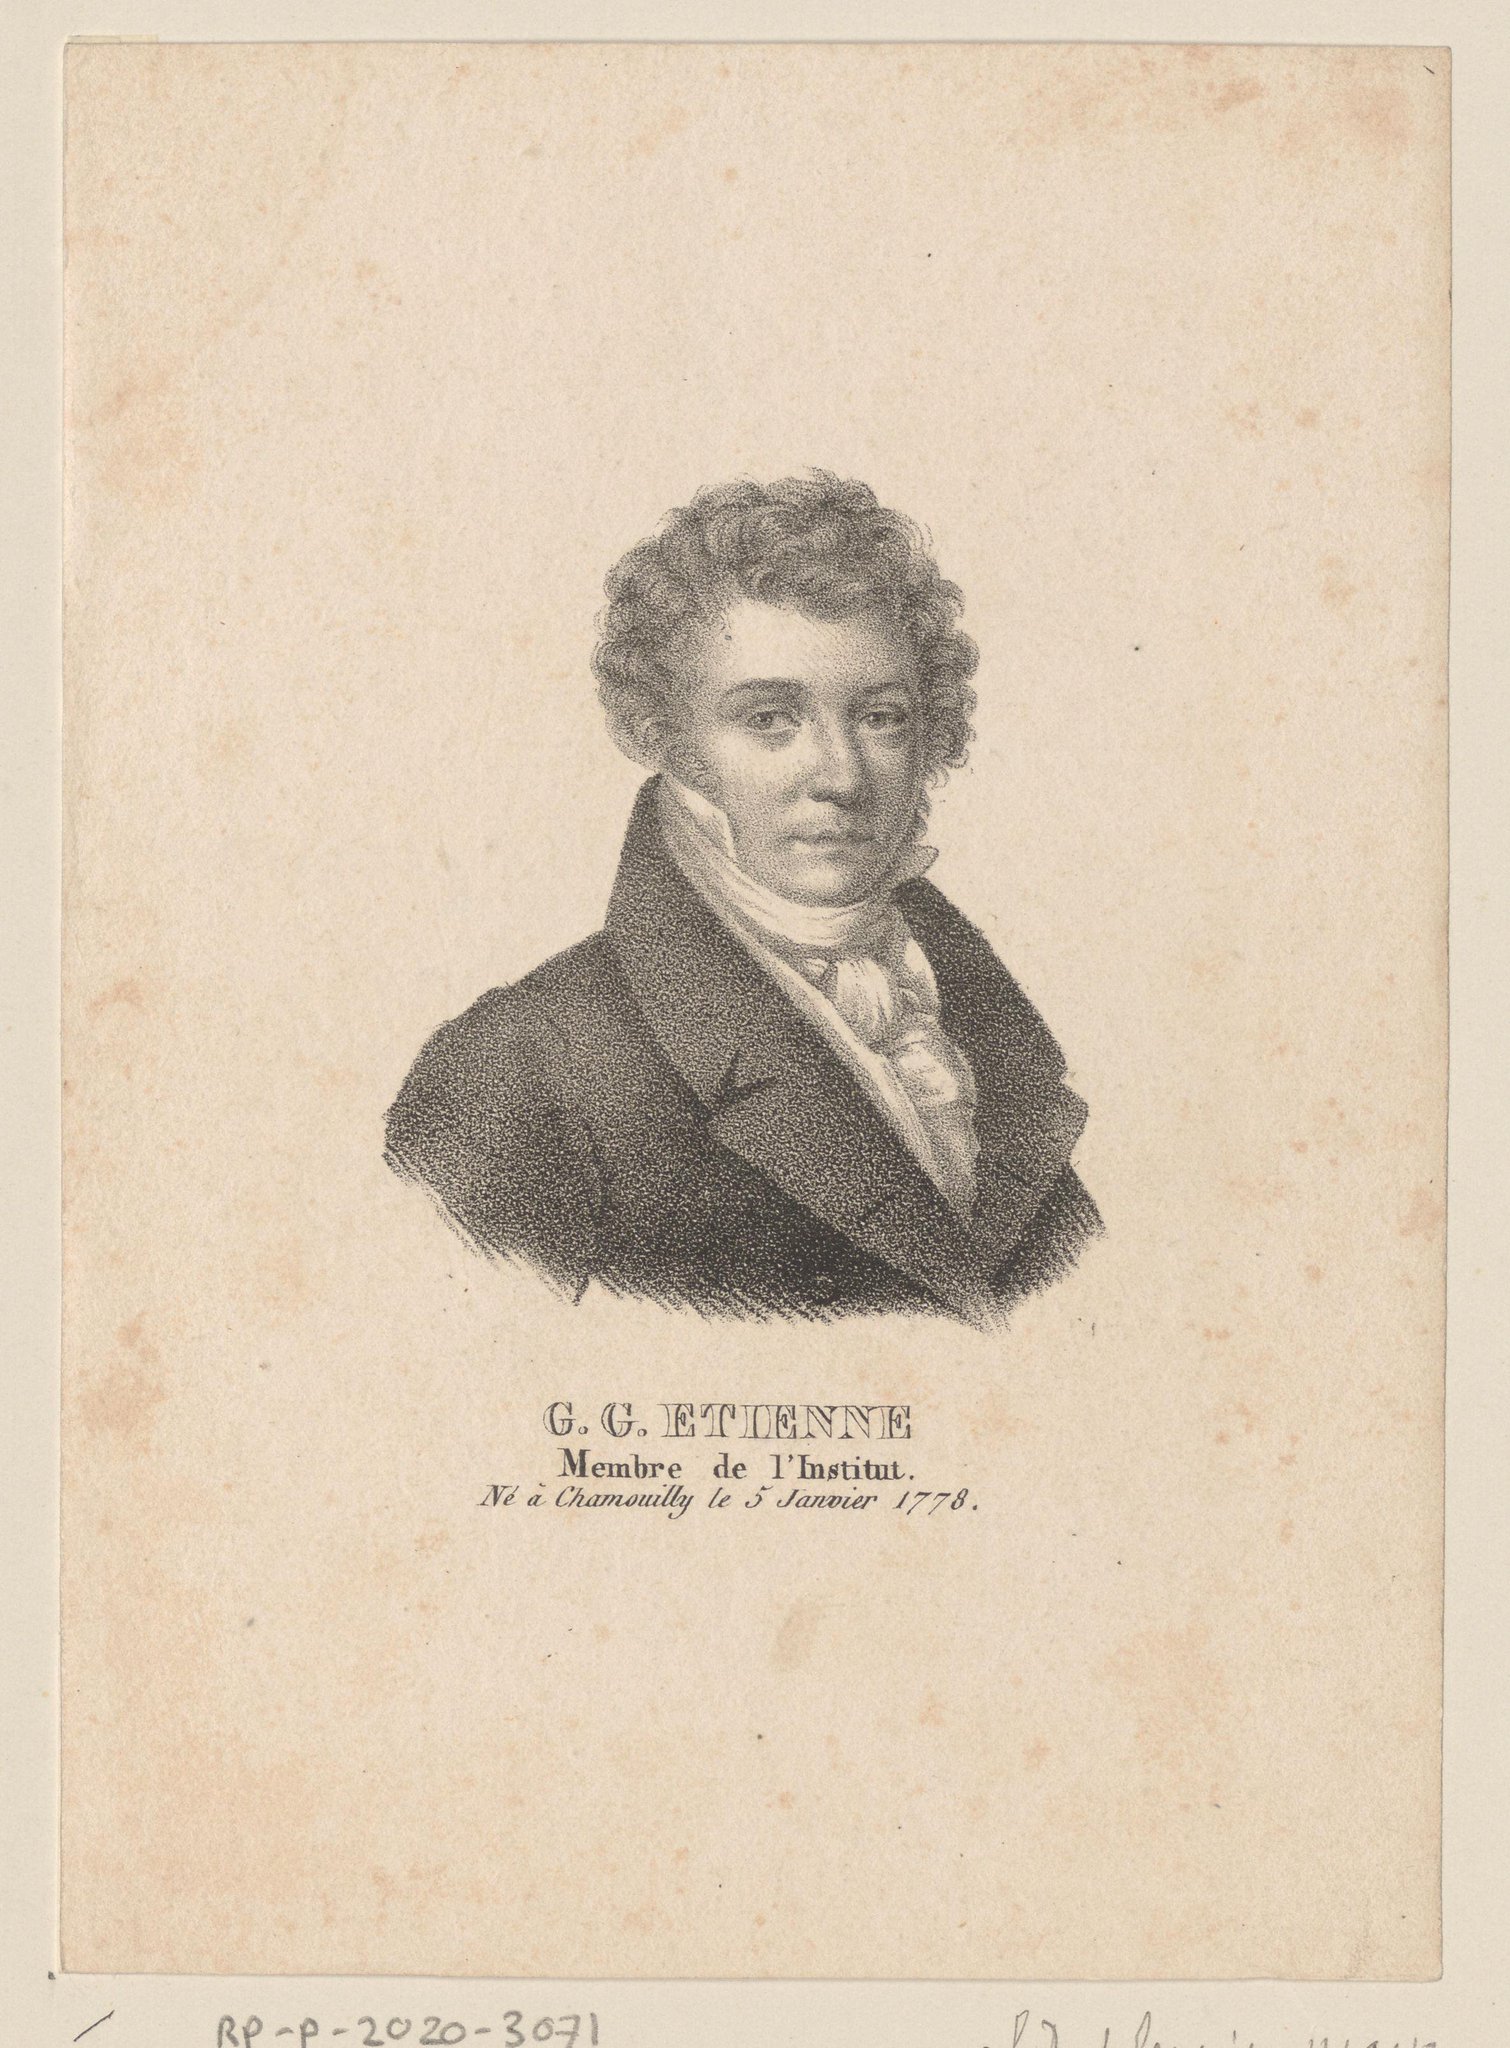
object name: print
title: Portret van Charles-Guillaume Étienne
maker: Anonymous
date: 1800-1850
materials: paper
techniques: lithograph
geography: france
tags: historical persons, portrait of a writer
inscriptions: inscription: ‘E No. 50’